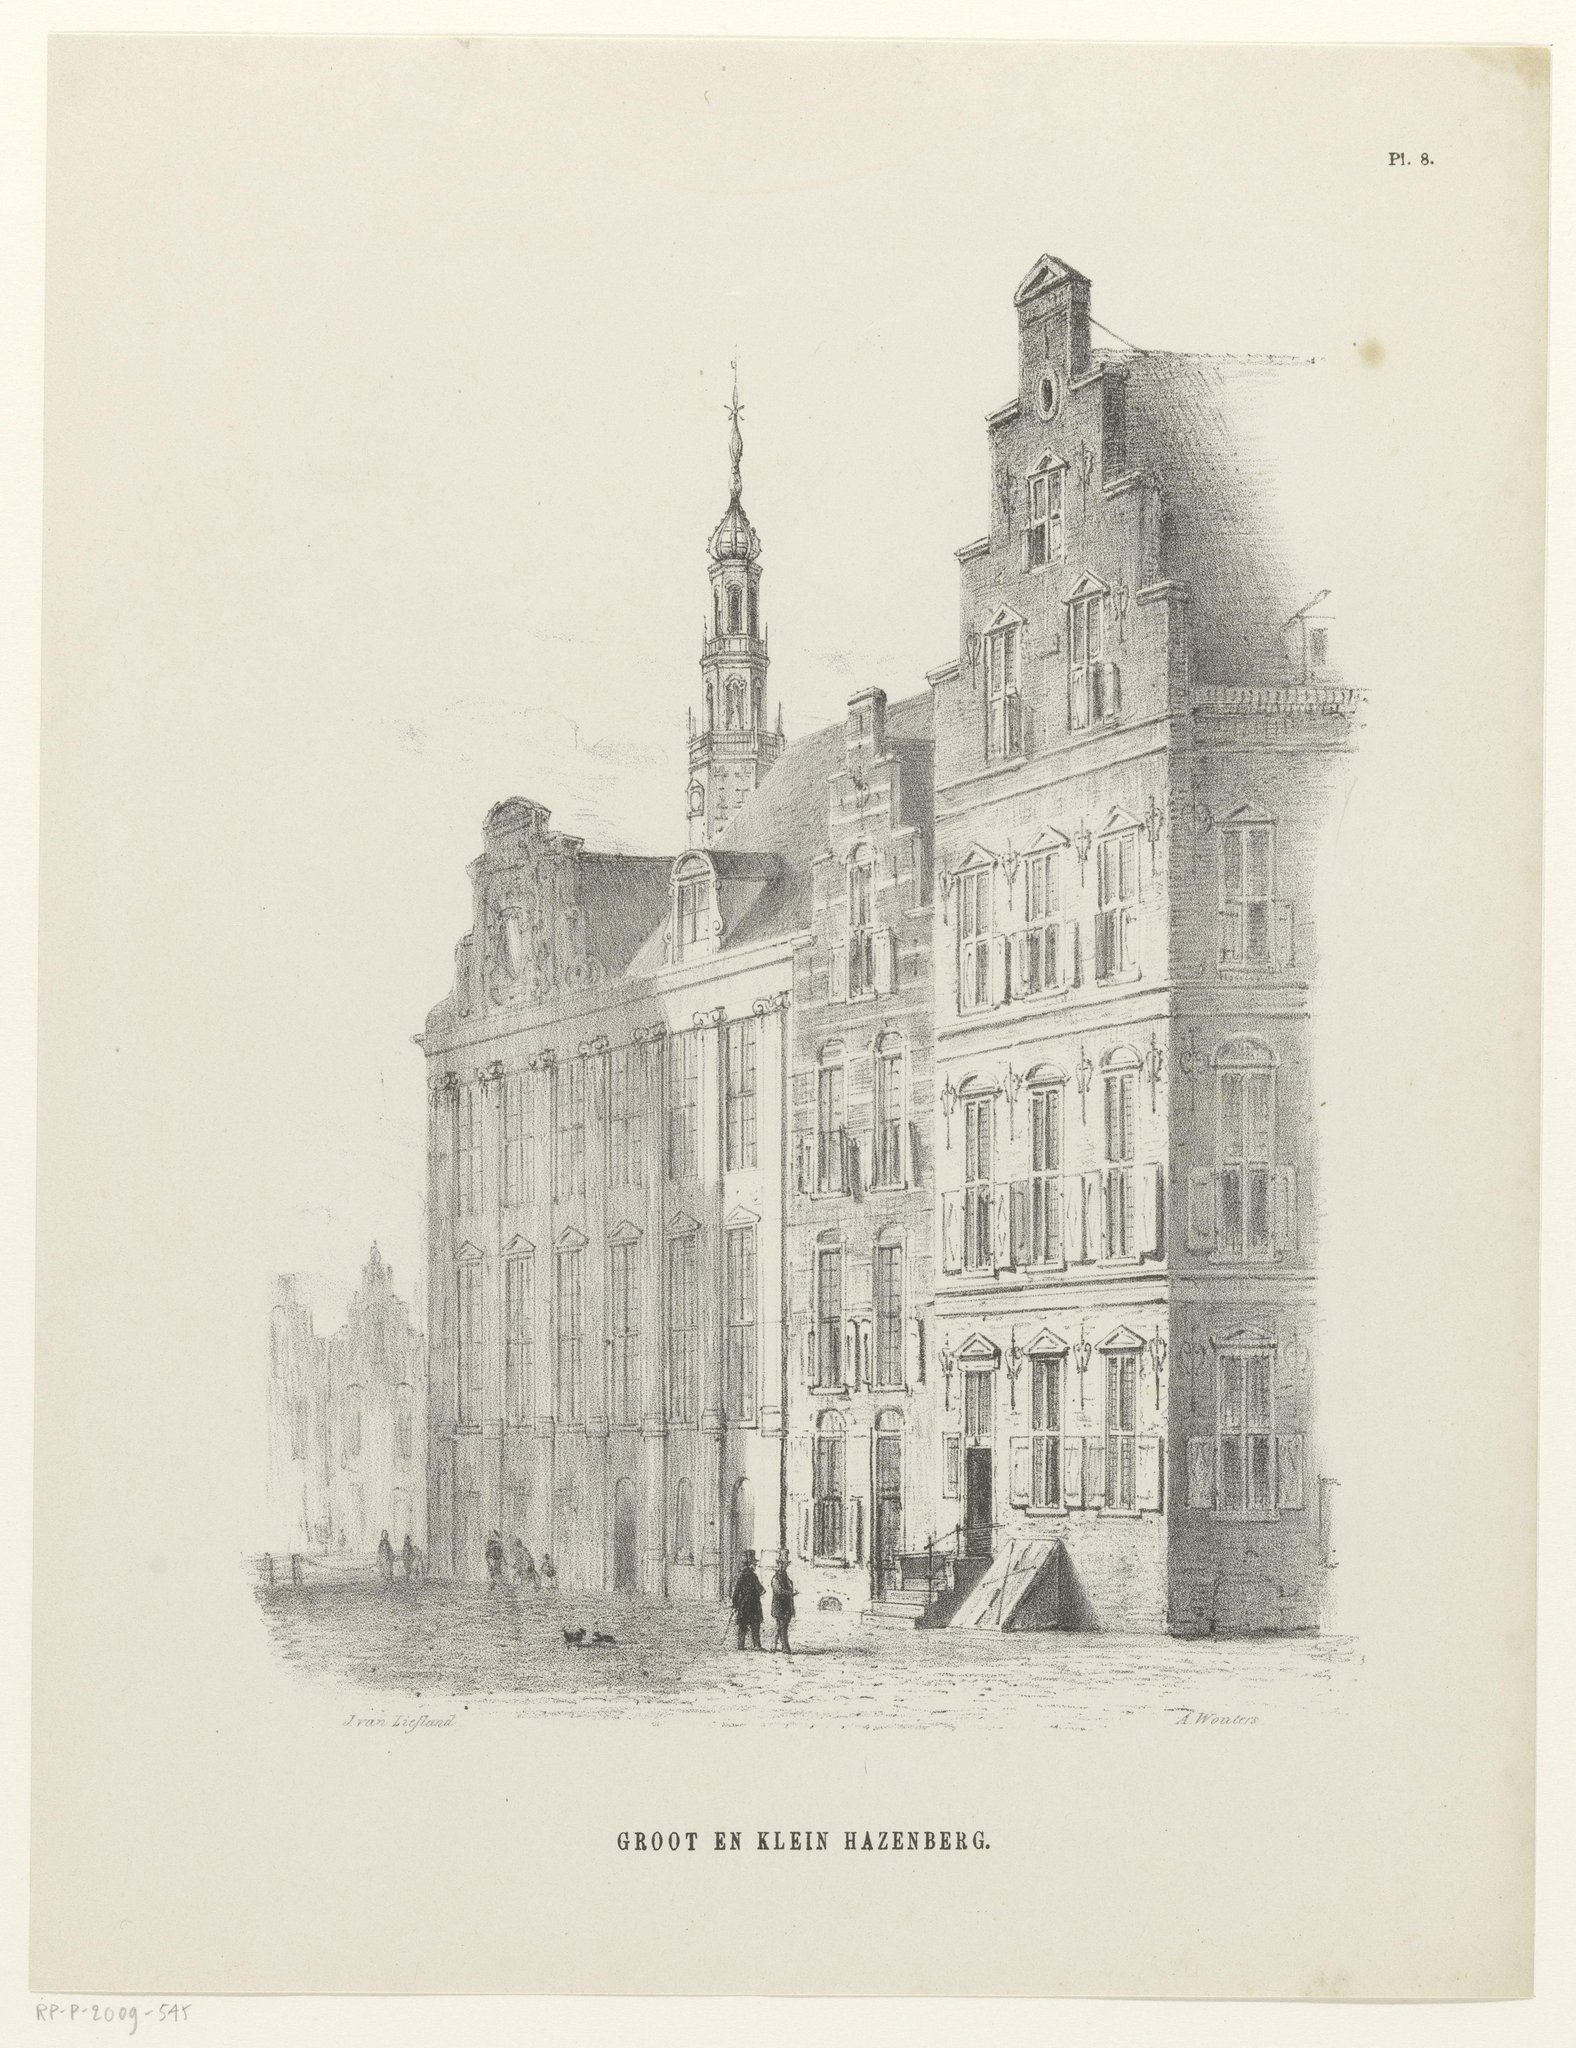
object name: print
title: Groot en Klein Hazenberg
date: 1857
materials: paper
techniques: lithograph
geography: utrecht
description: Gezicht op Groot en Klein Hazenberg. Gezicht op drie panden met trapgevels. Daarachter is nog een torenspits te zien. Onderaan de prent in het midden wandelen twee heren met hoge hoeden op. Links van hen twee honden. Plaat 8 uit een reeks.